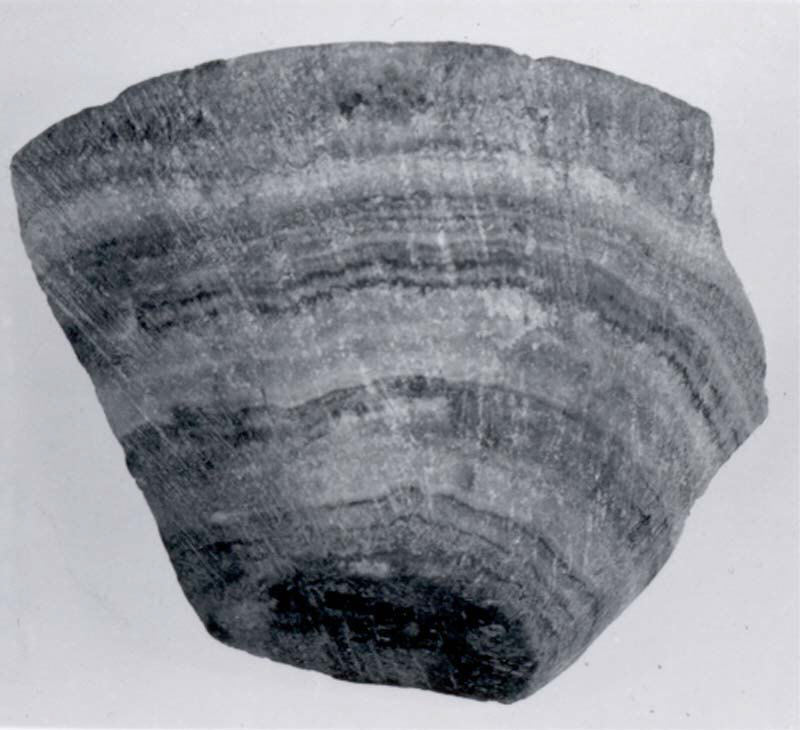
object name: cup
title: Cup fragment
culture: indus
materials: alabaster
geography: indus region